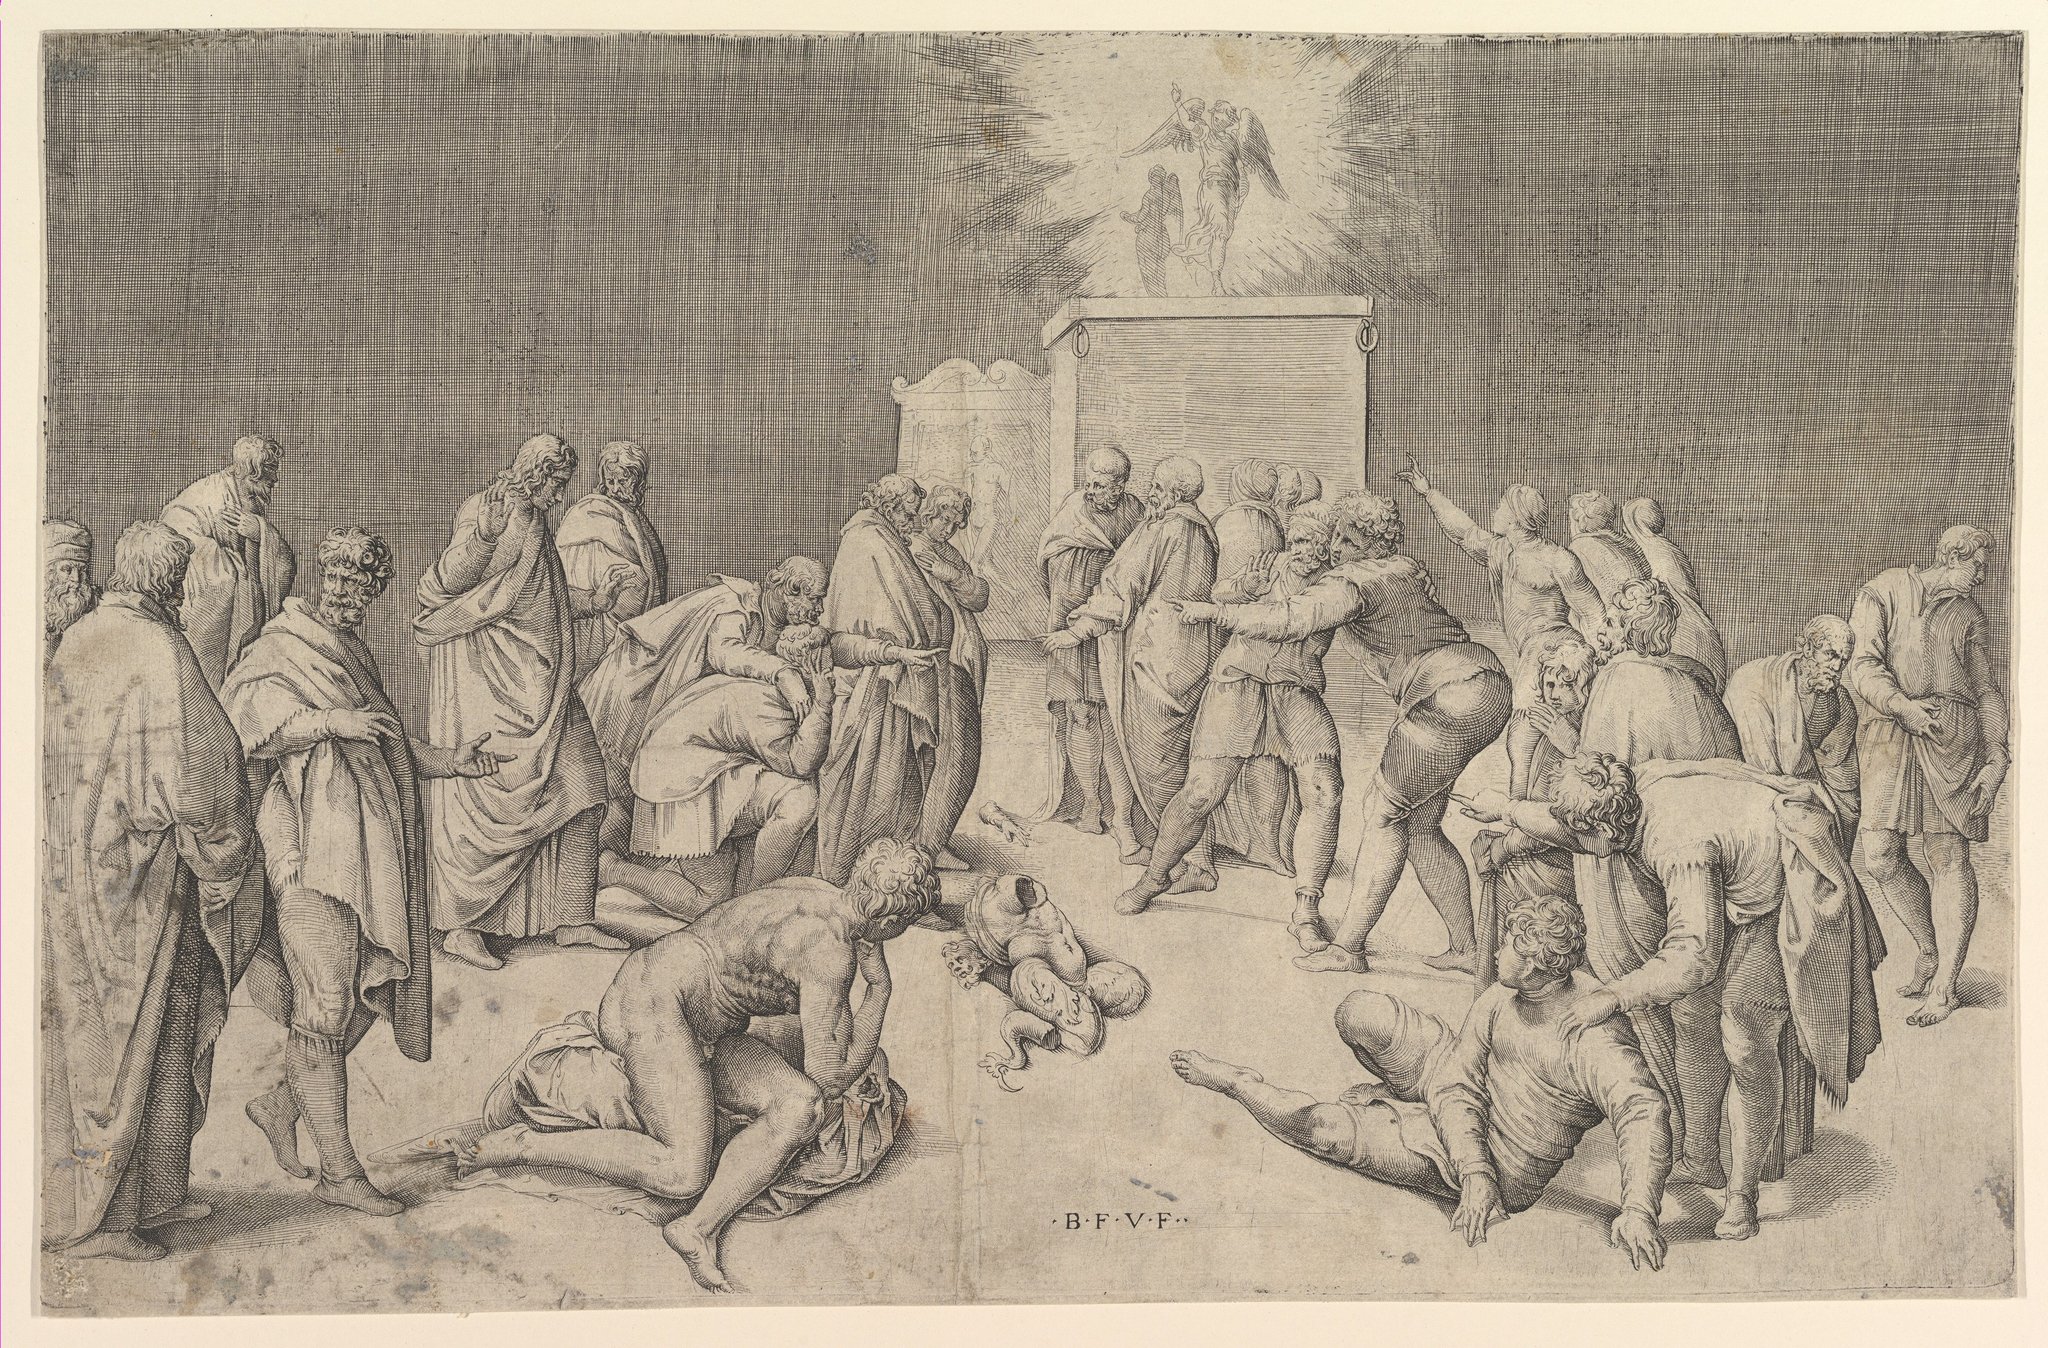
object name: print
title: The Philistines Place the Ark of the Covenant in the Temple of Dagon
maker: battista franco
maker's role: artist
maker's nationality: italian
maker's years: 1510-1561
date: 1540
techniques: engraving, etching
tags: temples,men